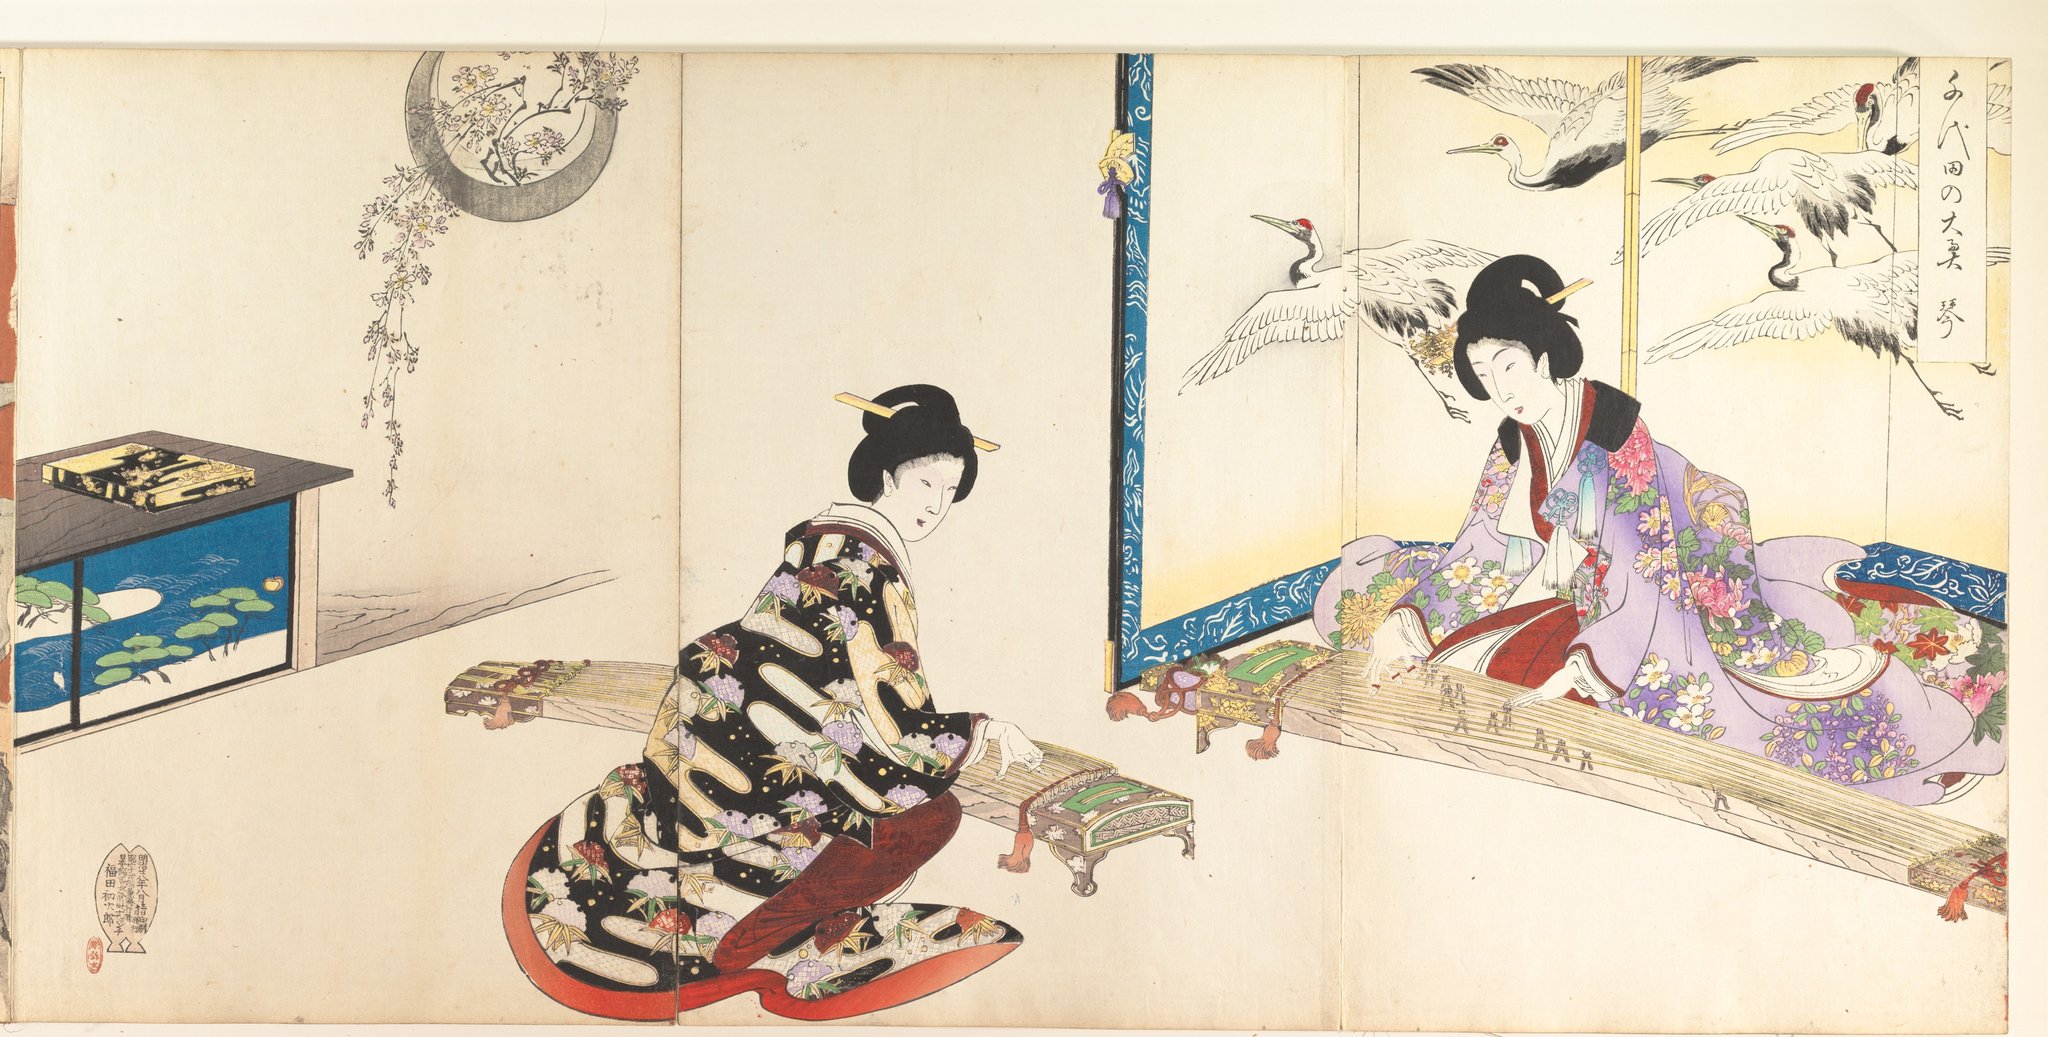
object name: print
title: Chiyoda Castle (Album of Women)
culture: japanese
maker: yōshū (hashimoto) chikanobu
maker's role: artist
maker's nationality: japanese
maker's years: 1838-1912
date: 1895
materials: ink, paper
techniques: woodblock print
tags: birds,women